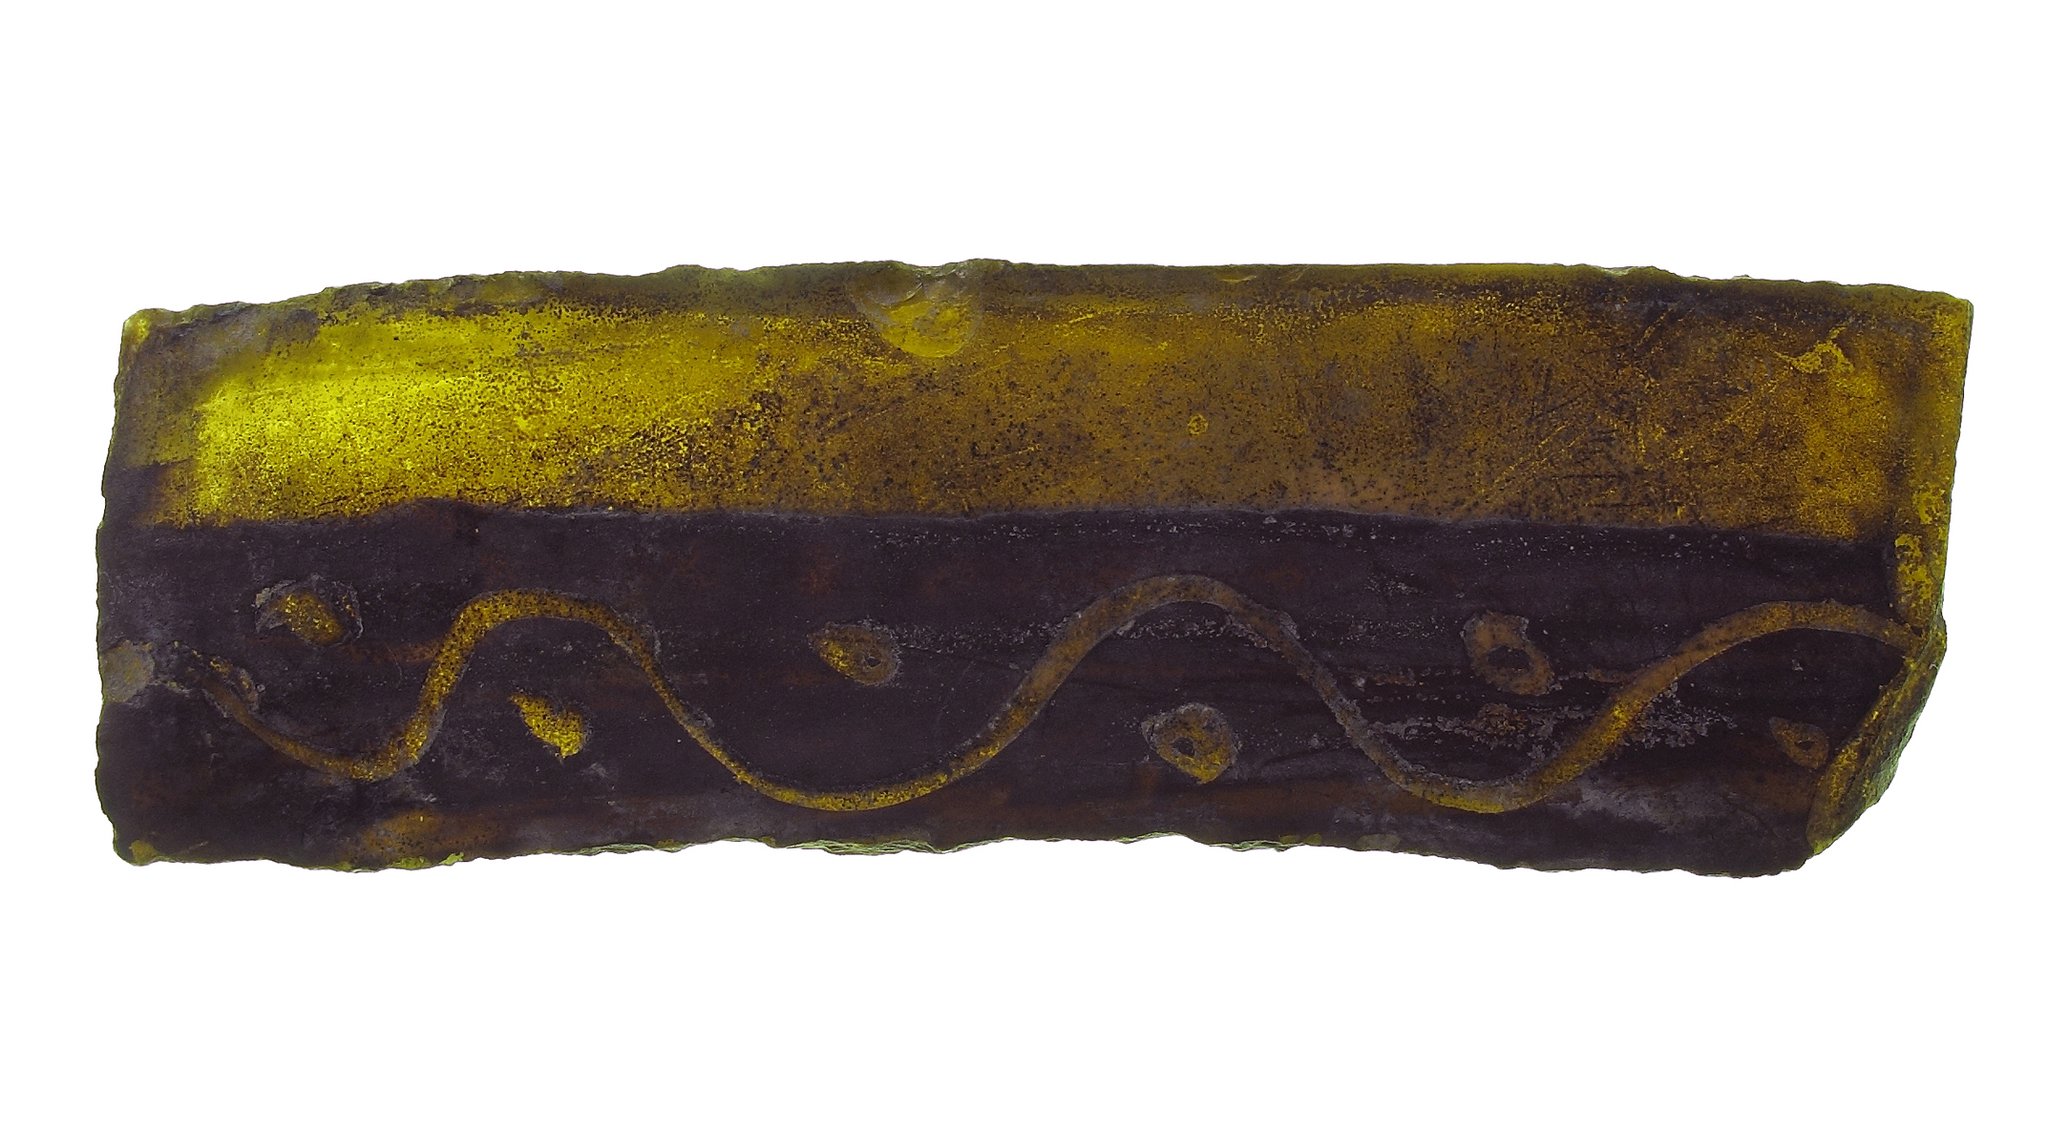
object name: fragment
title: Glass Fragment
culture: european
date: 1301-1400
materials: glass, metal